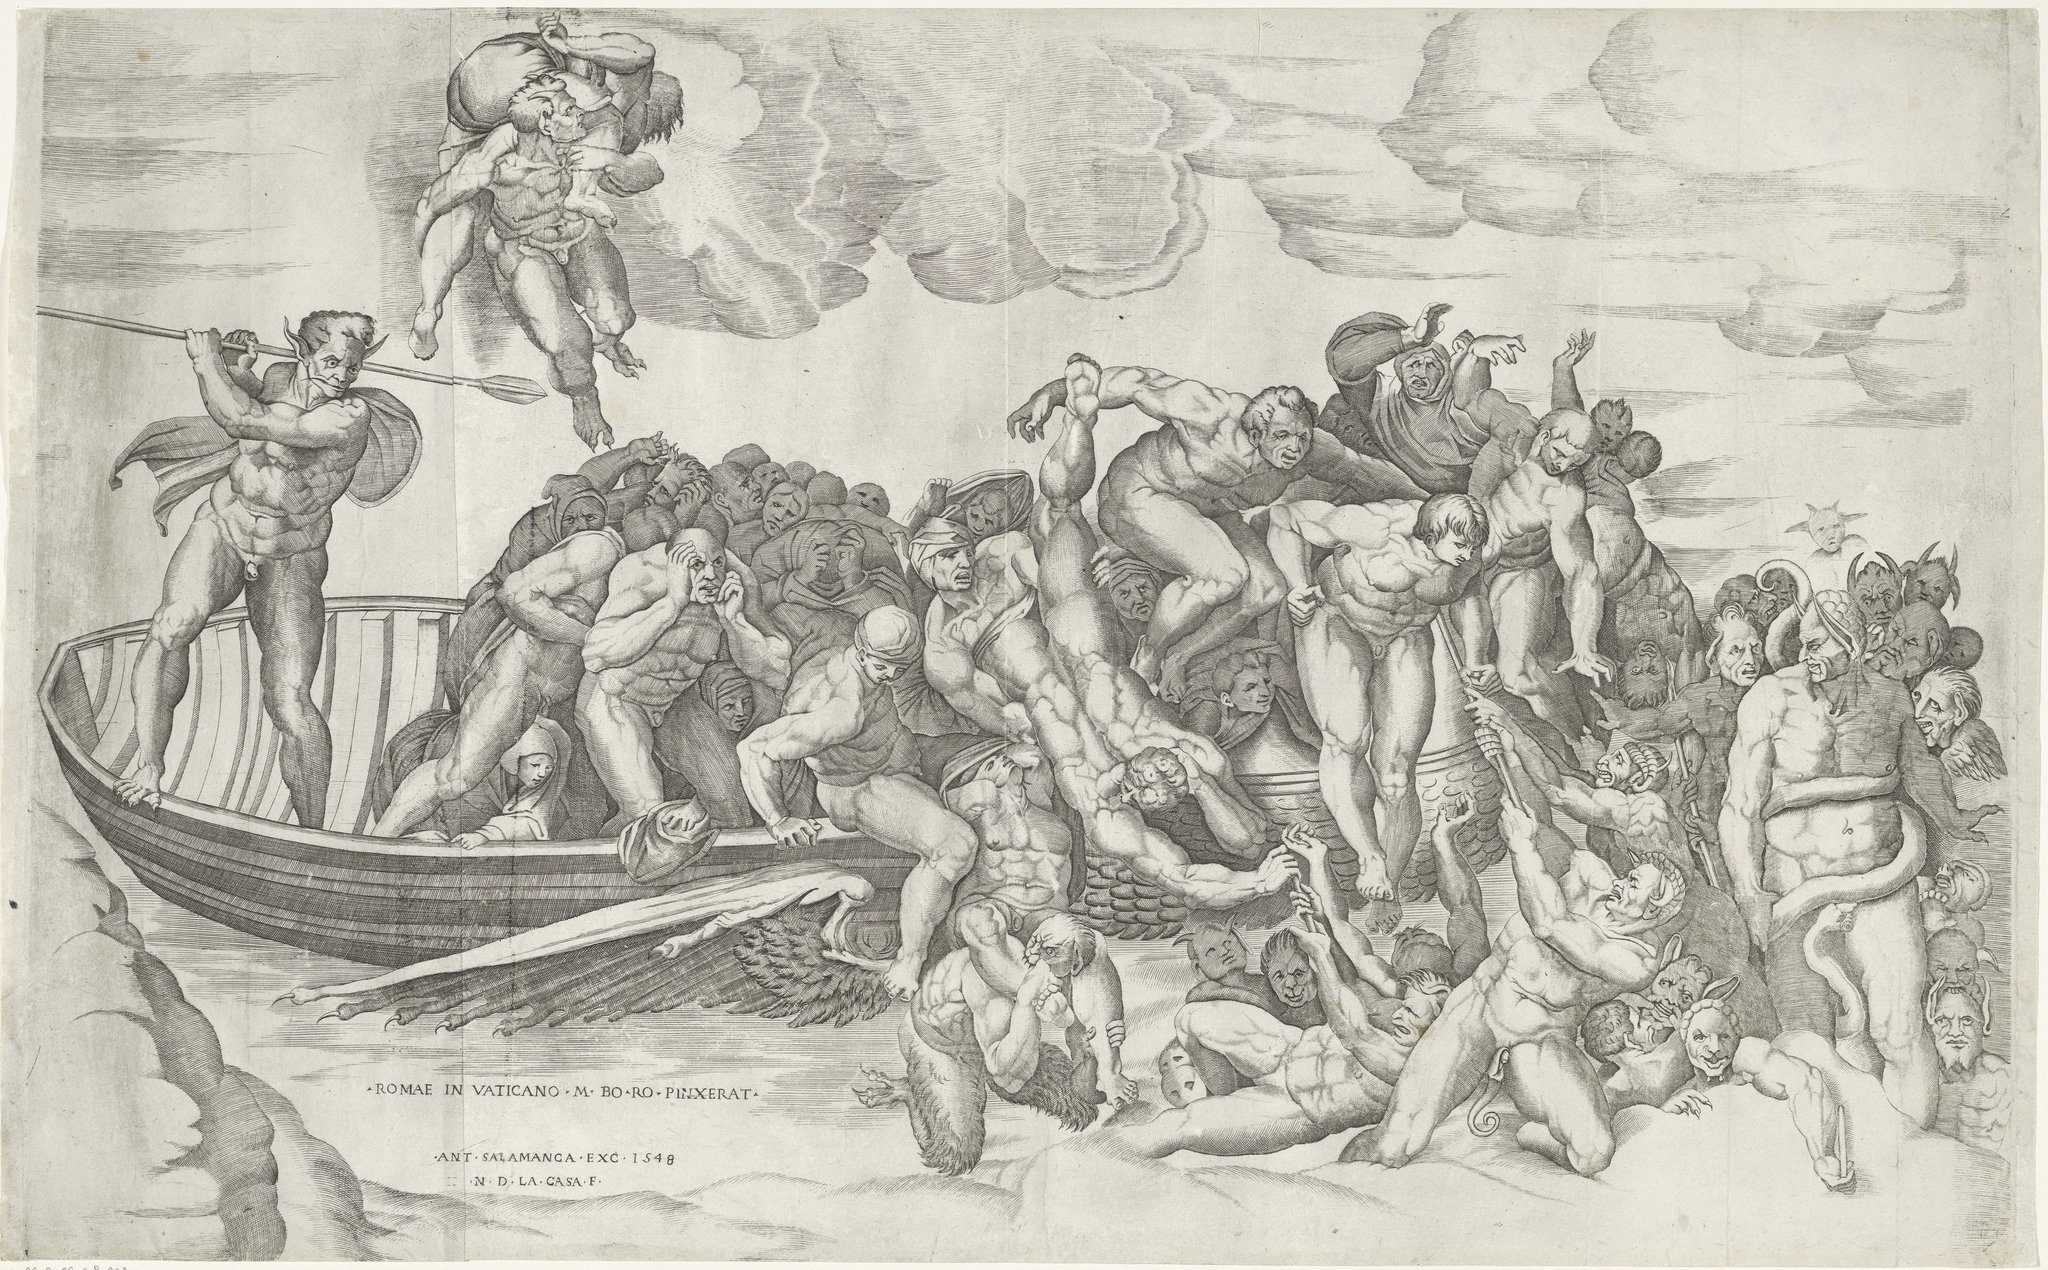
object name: print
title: Het laatste oordeel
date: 1548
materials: paper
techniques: engraving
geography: vatican city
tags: last judgement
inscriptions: collector's mark: Lugt 240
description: Prent maakt deel uit van een groep van twaalf prenten die samen één grote voorstelling vormen naar het fresco met het Laatste Oordeel door Michelangelo in de Sixtijnse Kapel in het Vaticaan.